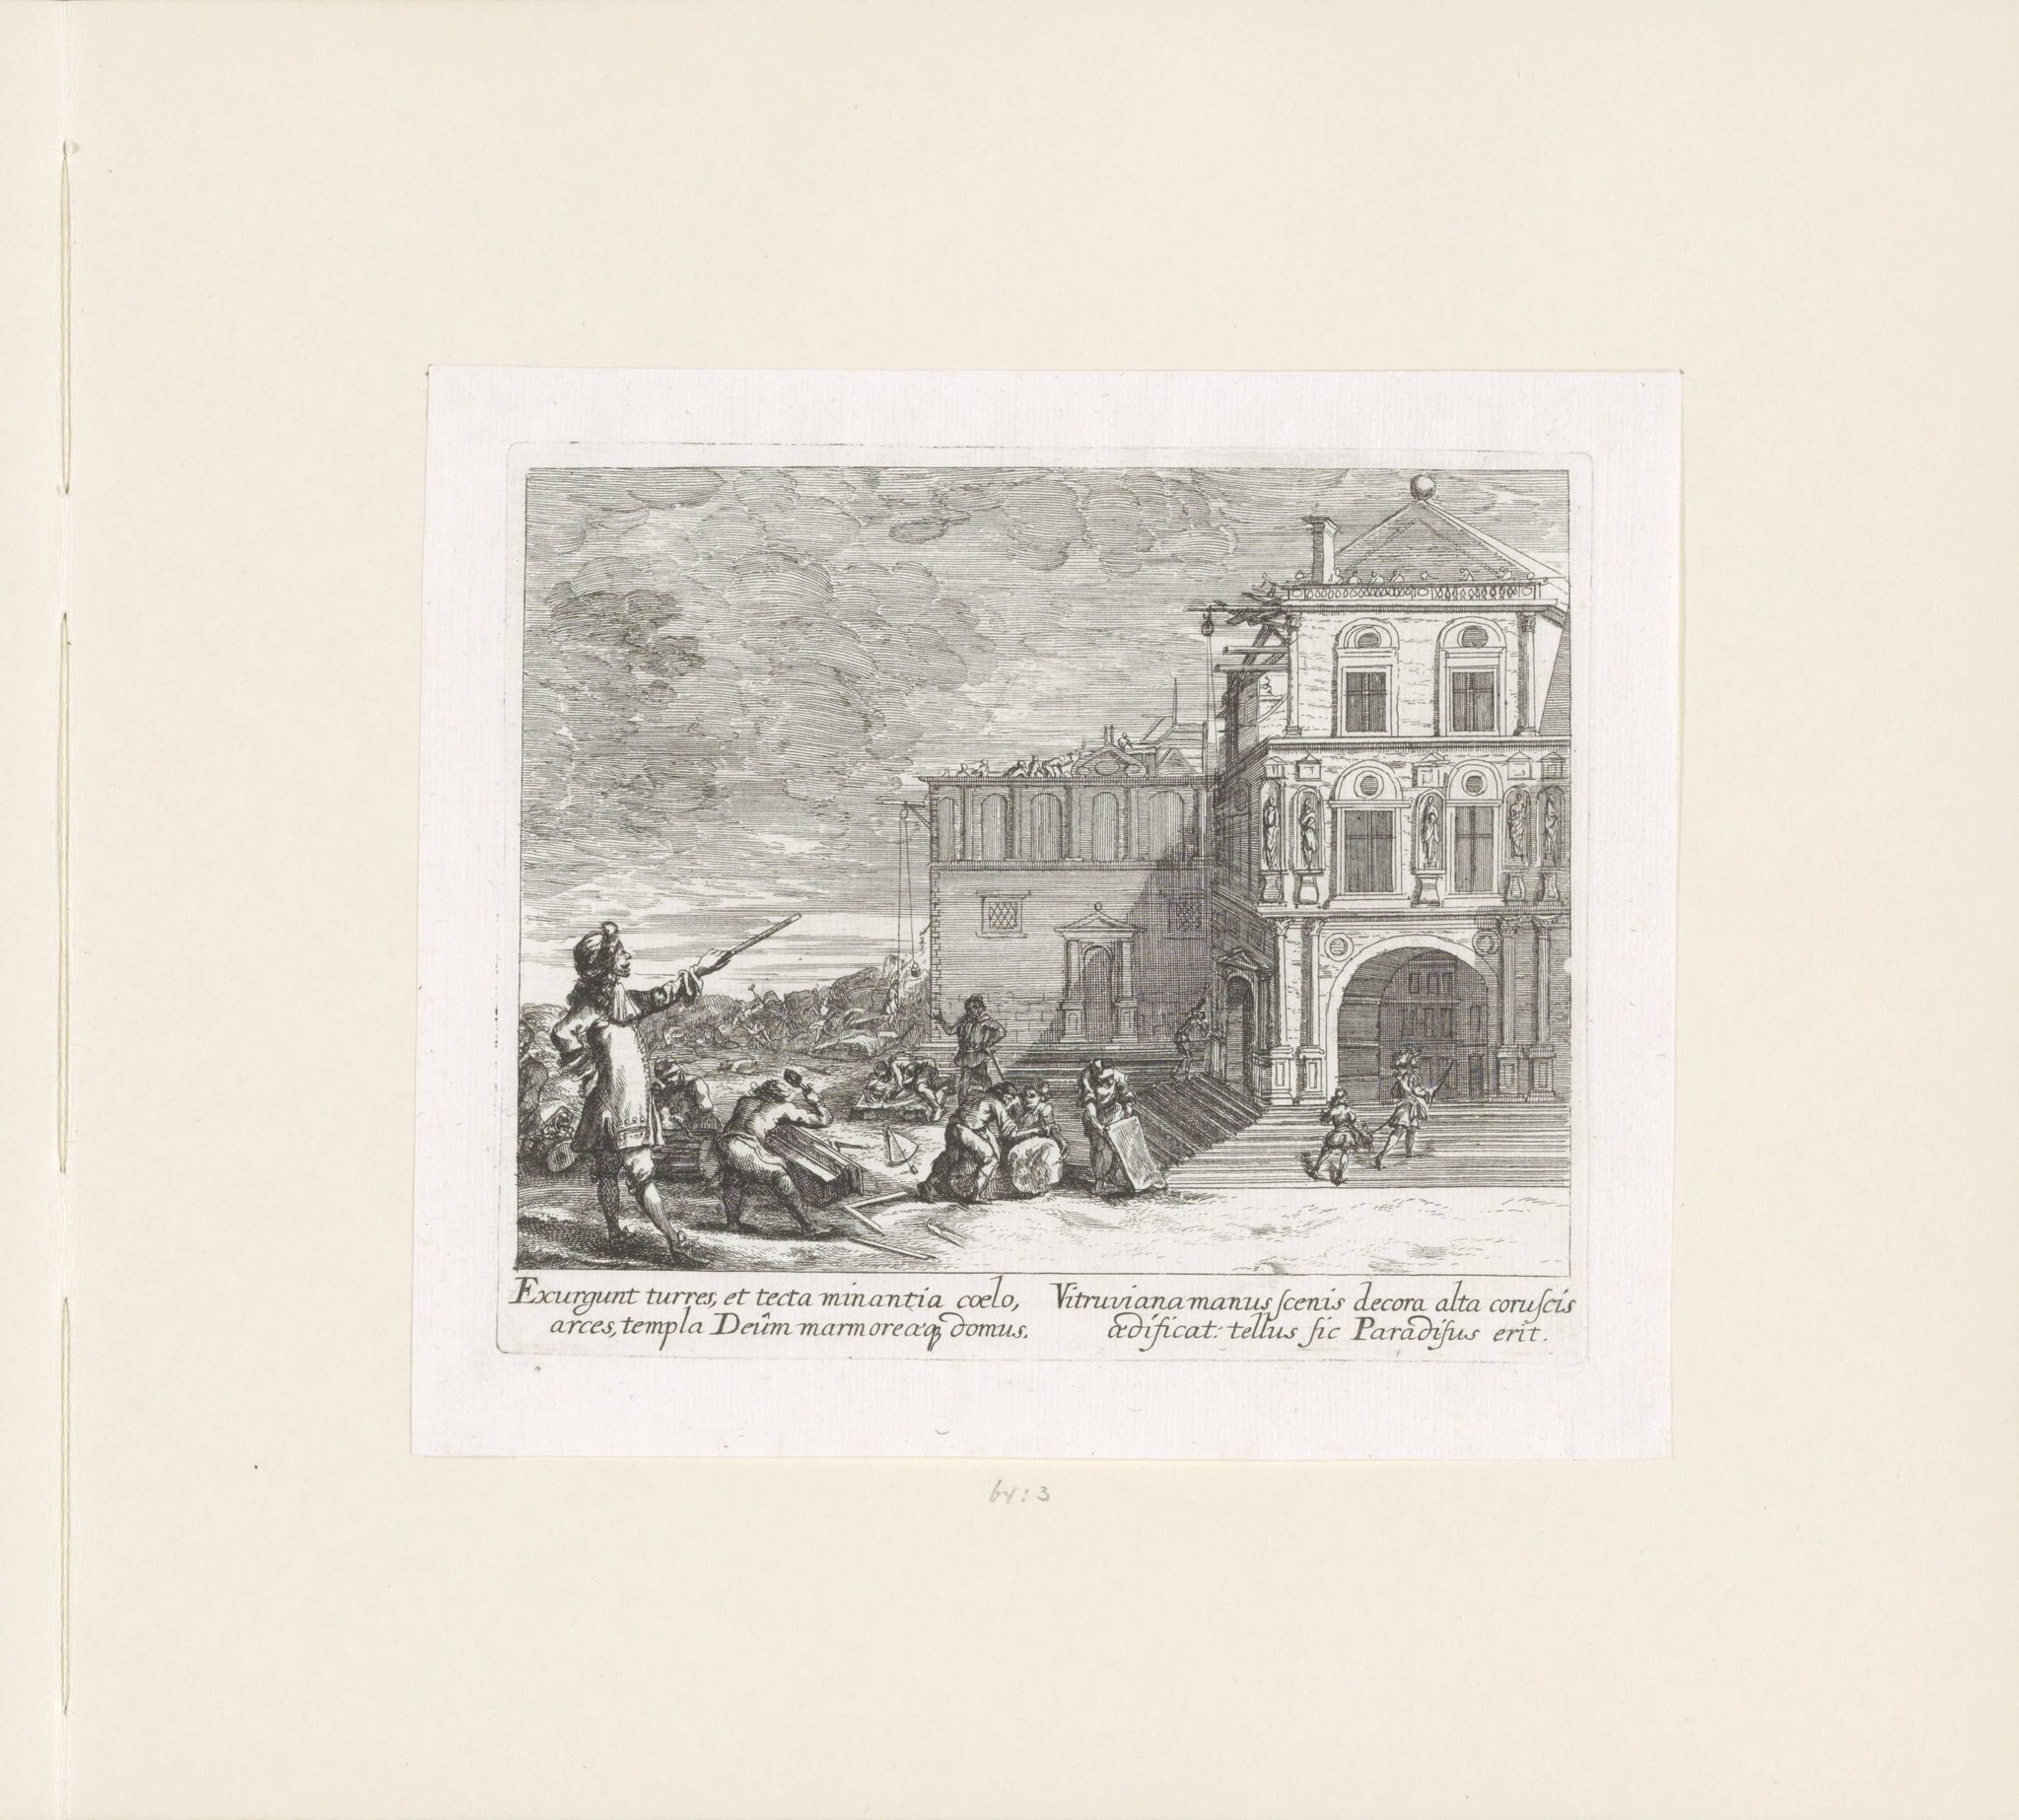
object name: album leaf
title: Architectuur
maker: mathäus küsel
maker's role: print maker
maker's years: 1629-1681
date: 1680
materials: paper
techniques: etching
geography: augsburg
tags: building activities, tools, aids, implements ~ crafts and industries: tackle, building of church, building-site, architect supervising building activities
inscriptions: collector's mark: Lugt 964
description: Bouwplaats van een kerk. Een man geeft aanwijzingen aan zijn werknemers. Op verschillende plekken worden materialen naar het dak van de kerk getakeld. Onder de voorstelling vier regels tekst in het Latijn. De prent maakt deel uit van een album.